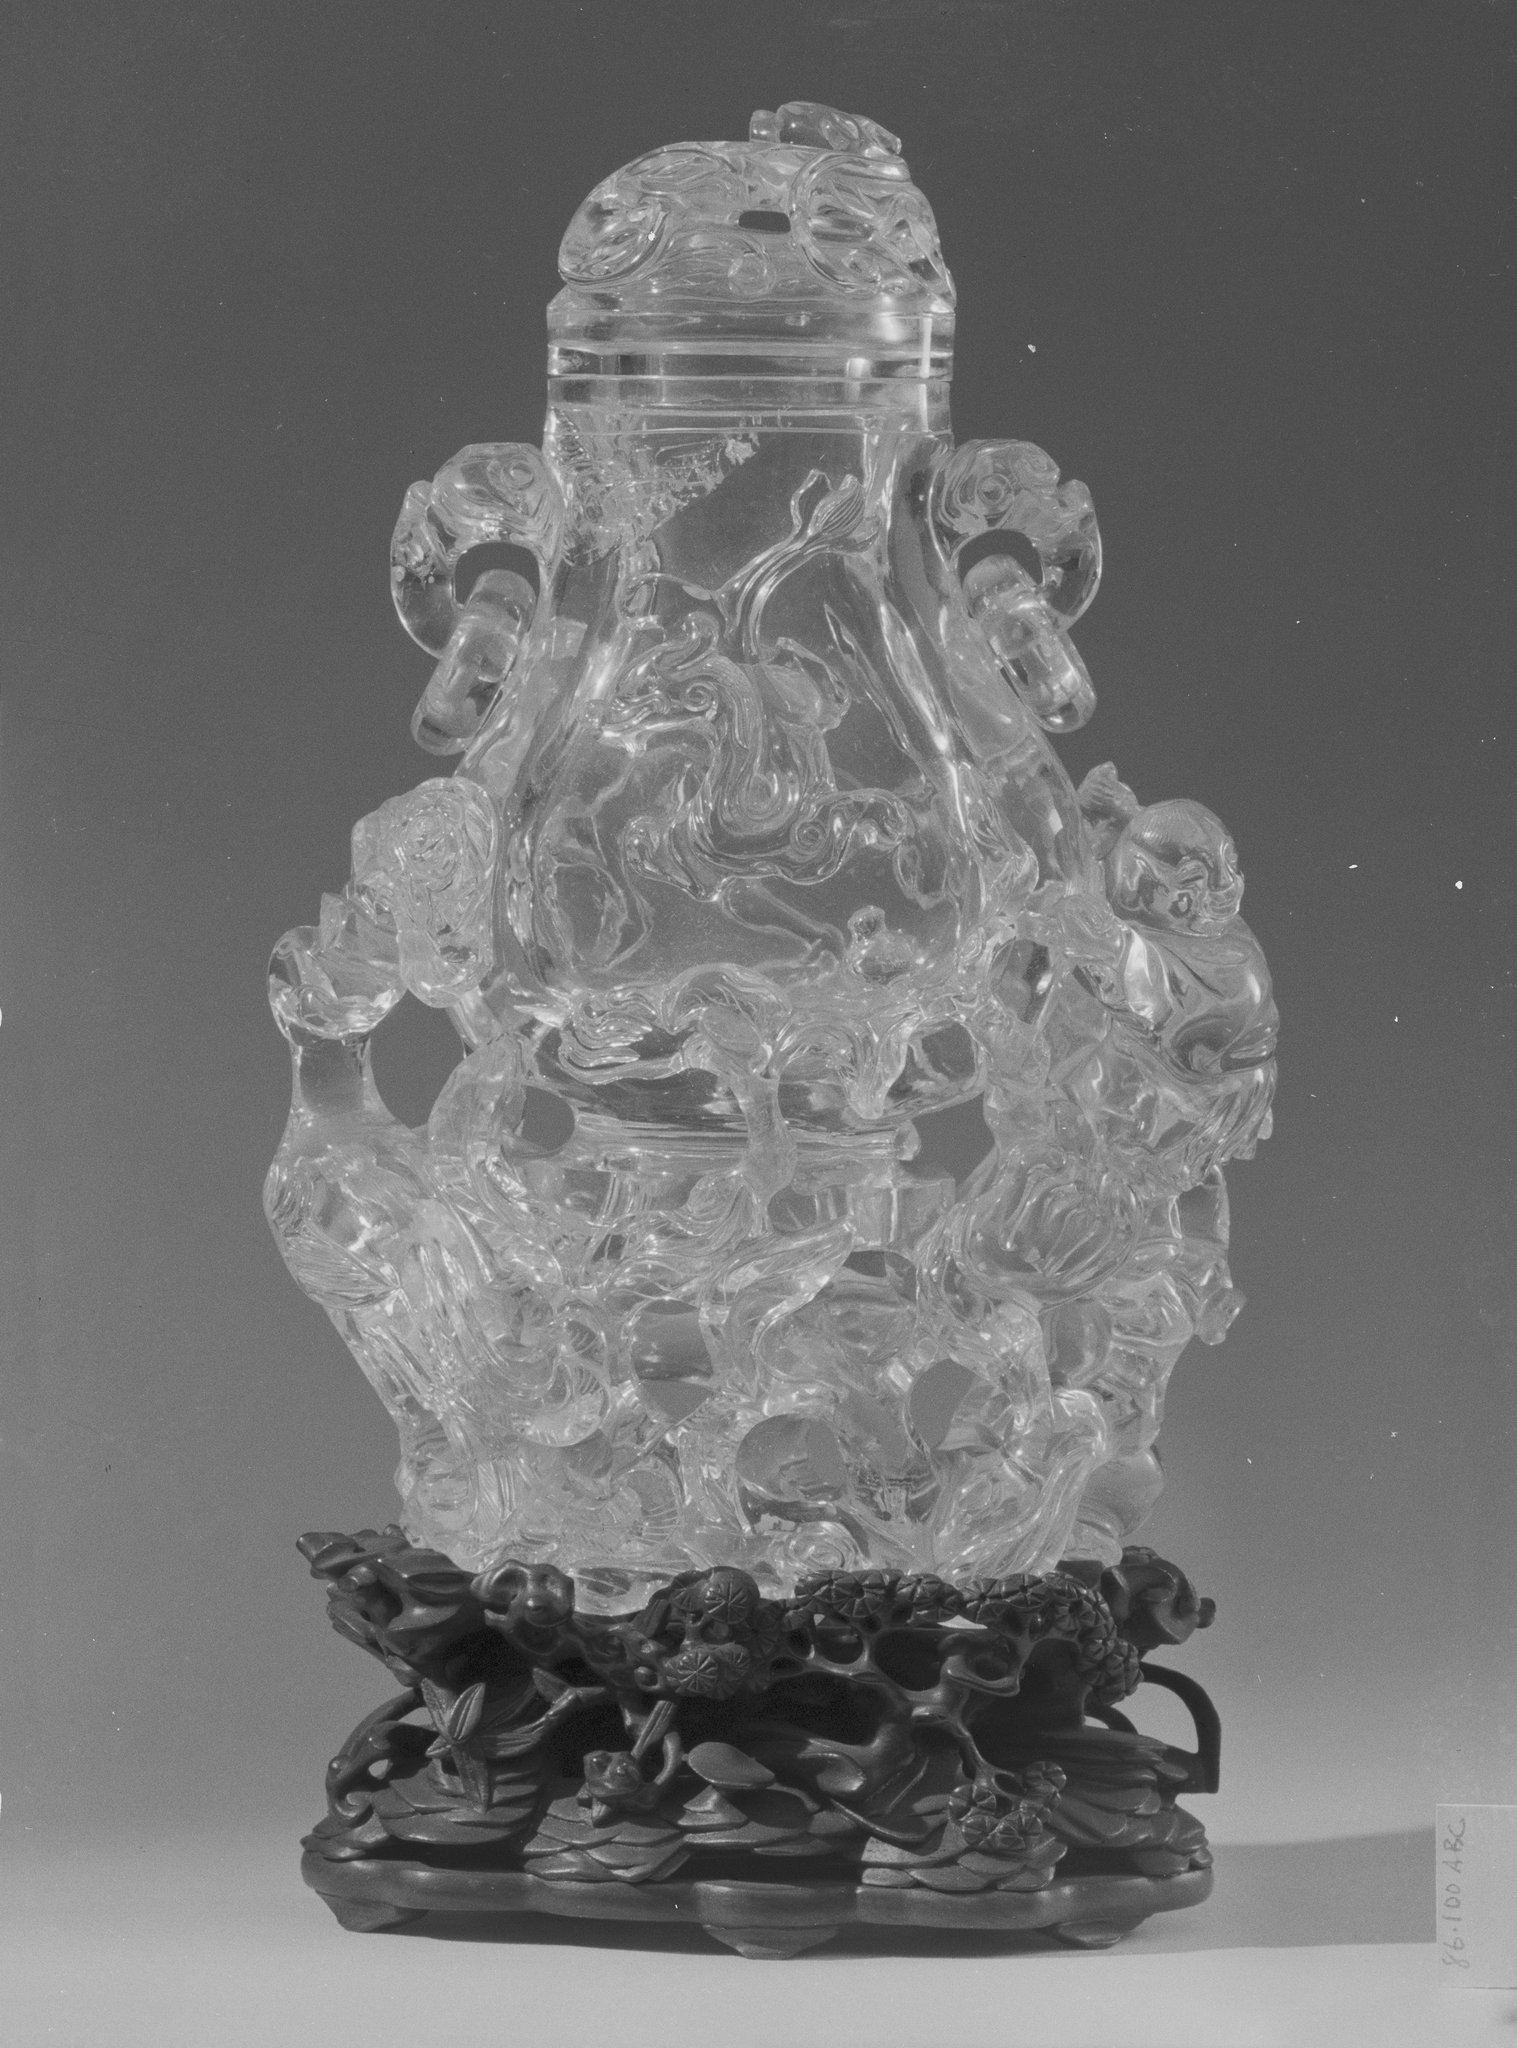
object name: covered vase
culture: chinese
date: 1867-1900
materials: quartz